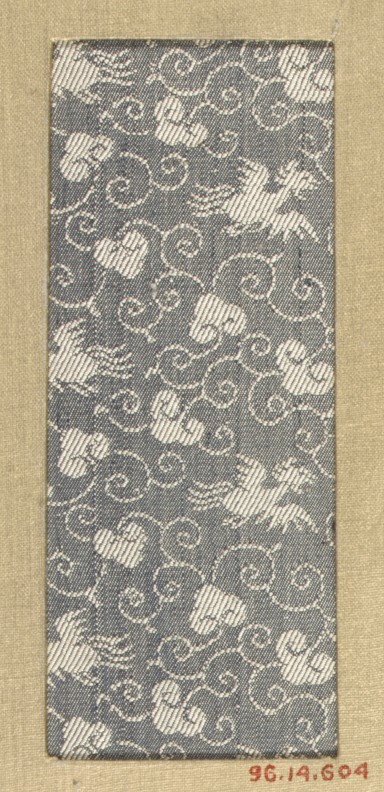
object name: piece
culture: japanese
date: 1701-1900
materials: silk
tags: mythical creatures